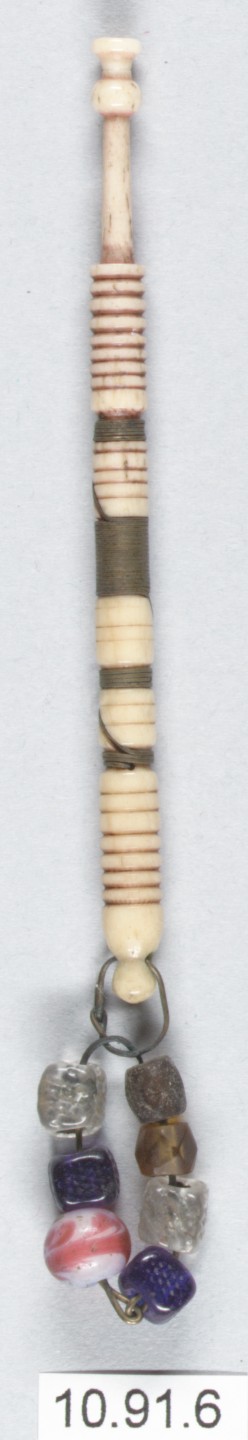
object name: bobbin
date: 1801-1900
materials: bone, metal